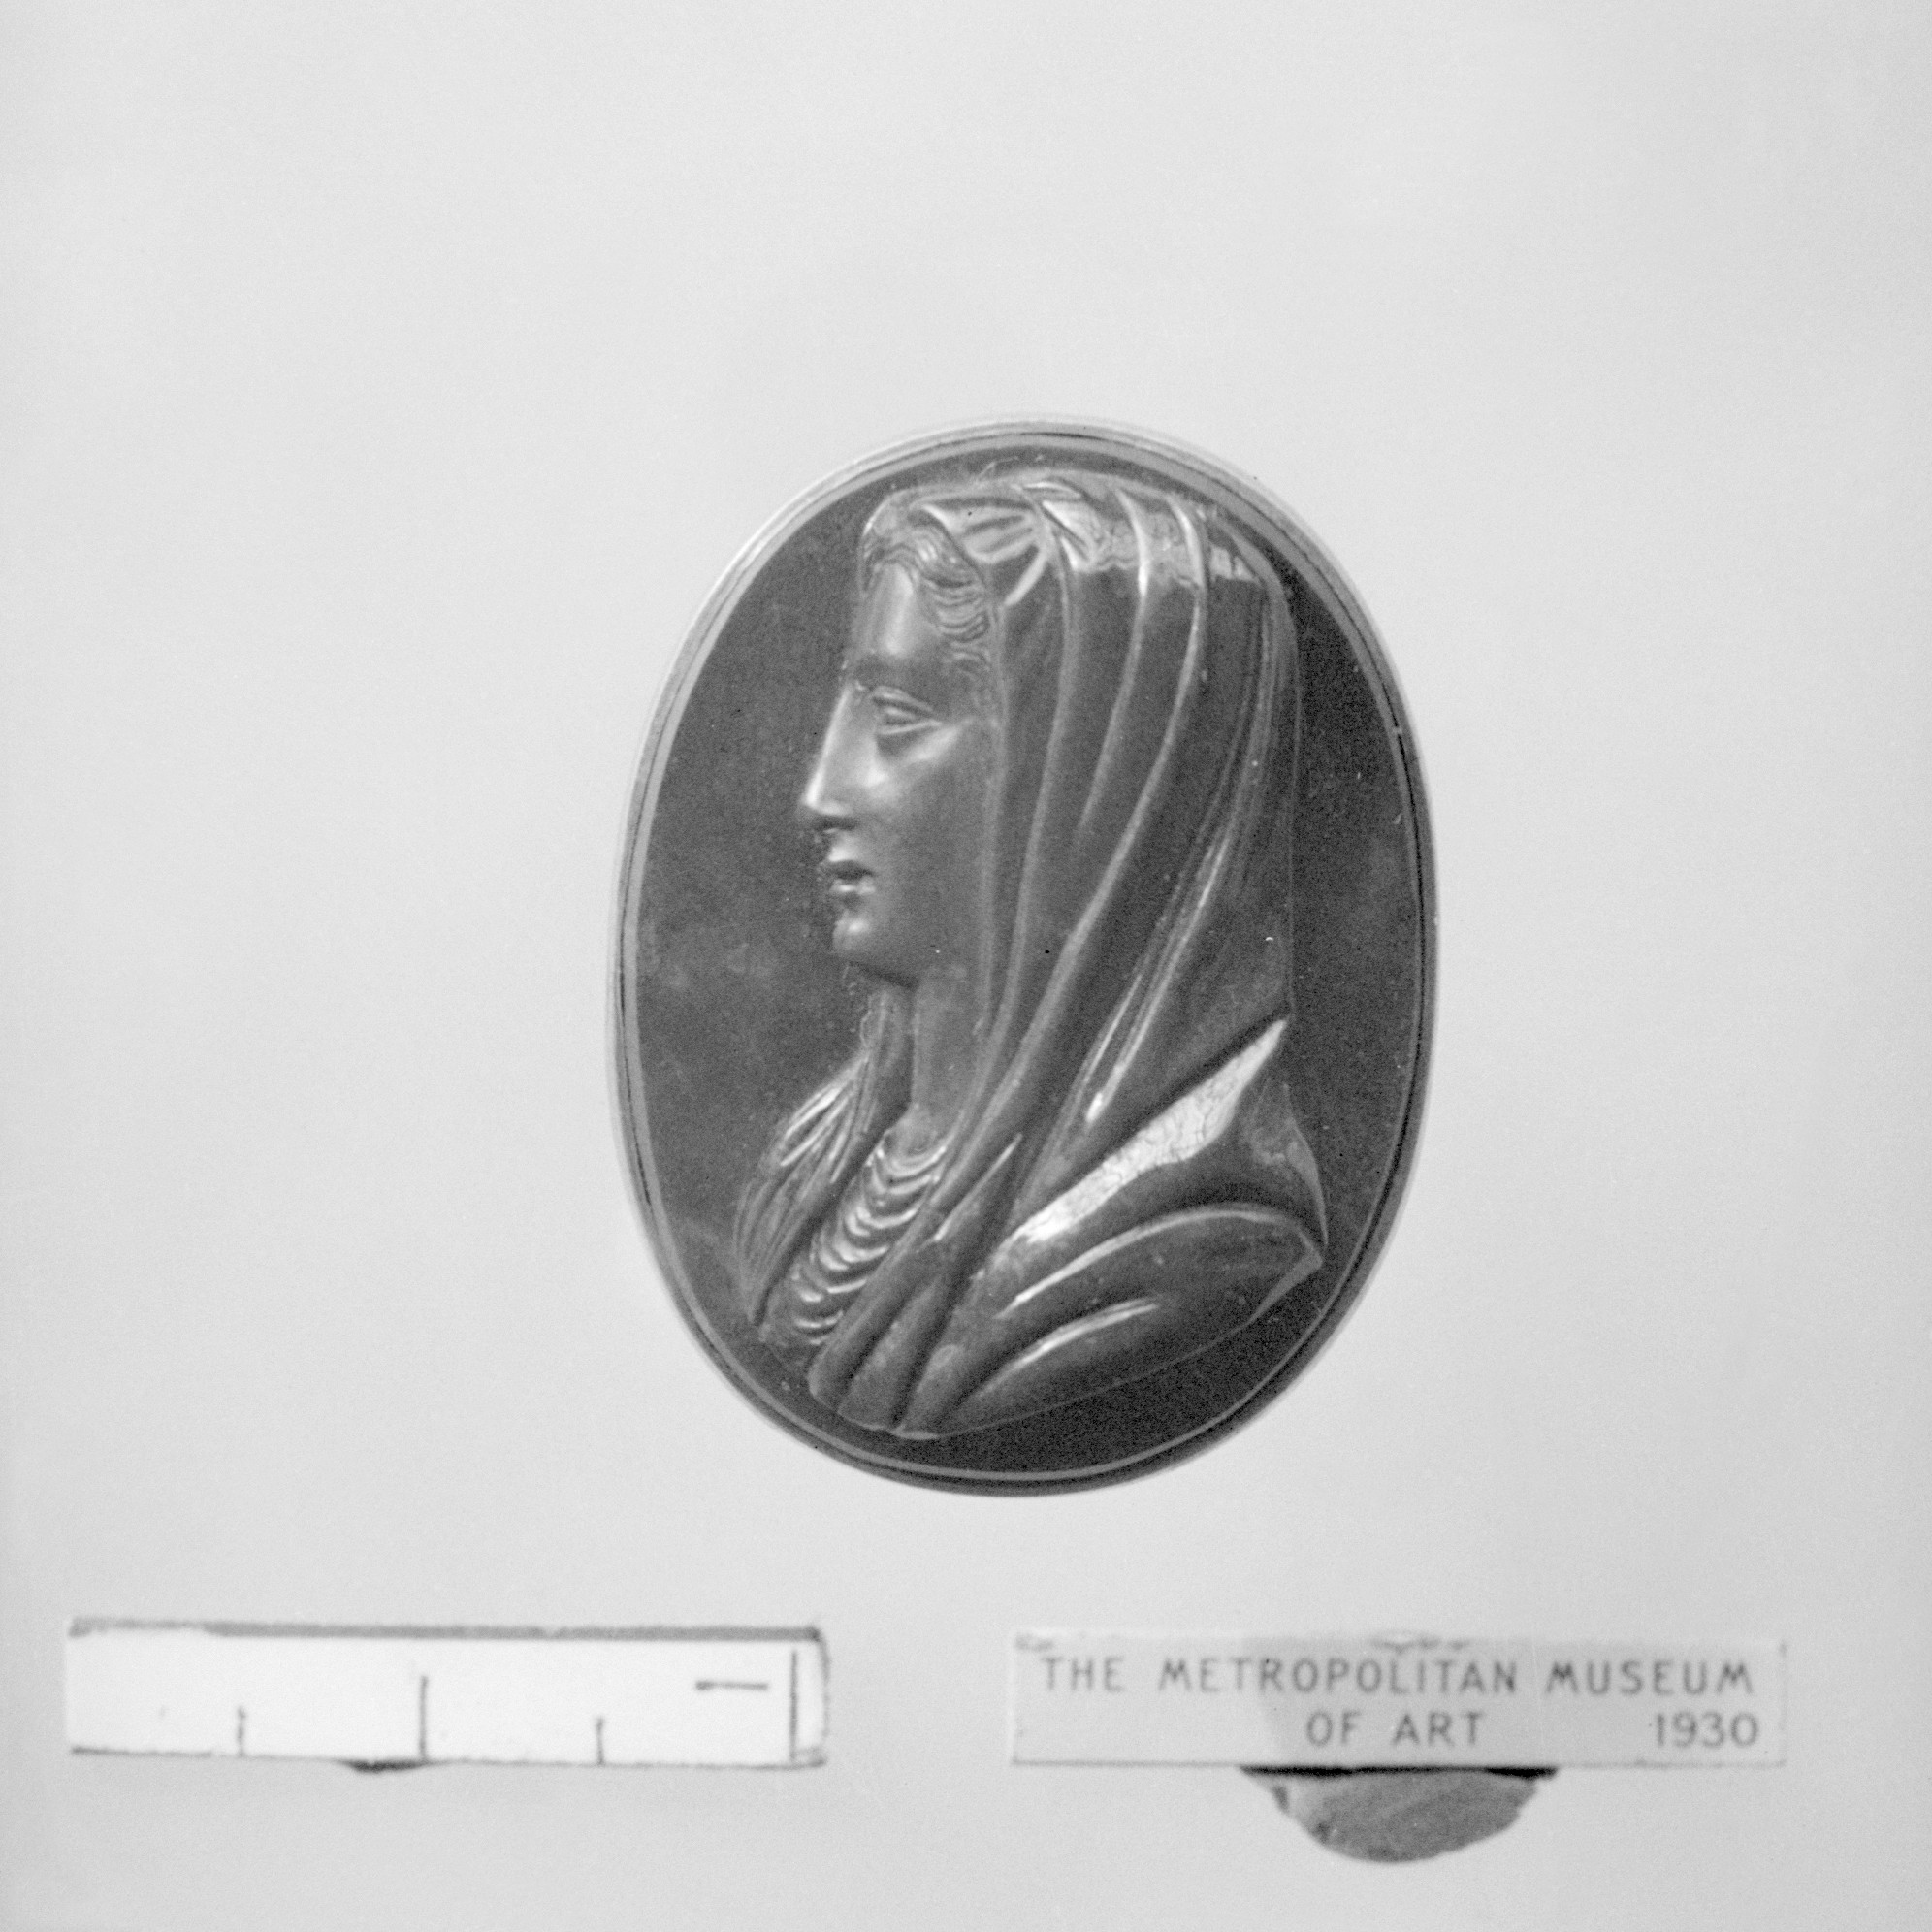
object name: cameo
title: The Virgin Mary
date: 1501-1700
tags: profiles,virgin mary